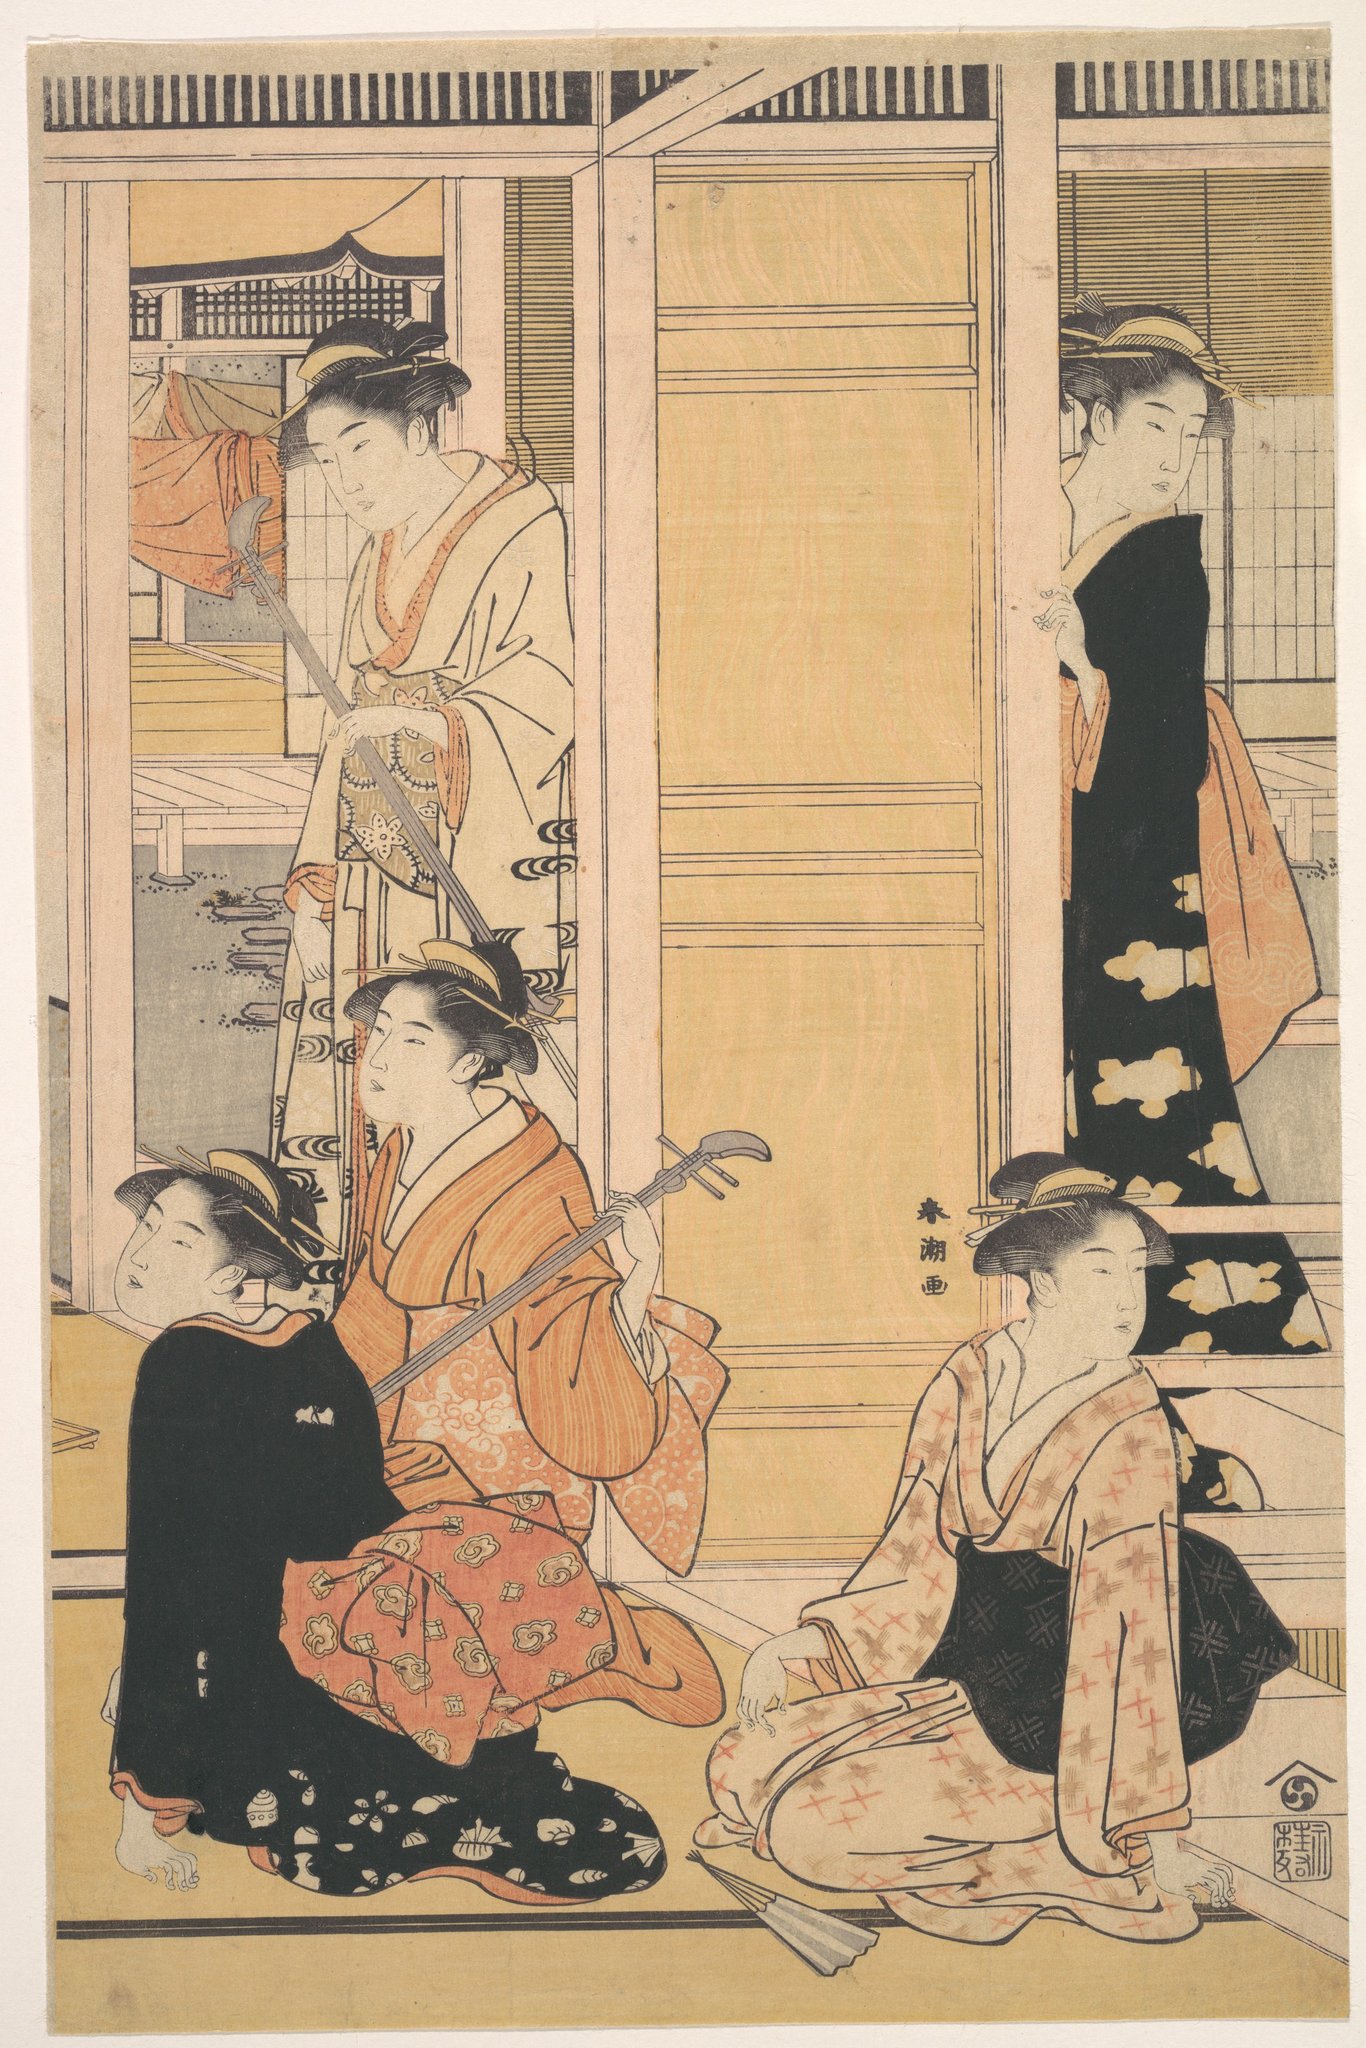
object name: print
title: Interior View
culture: japanese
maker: katsukawa shunchō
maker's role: artist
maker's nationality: japanese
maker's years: 1775-1795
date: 1788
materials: ink, paper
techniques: woodblock print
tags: musical instruments,interiors,women